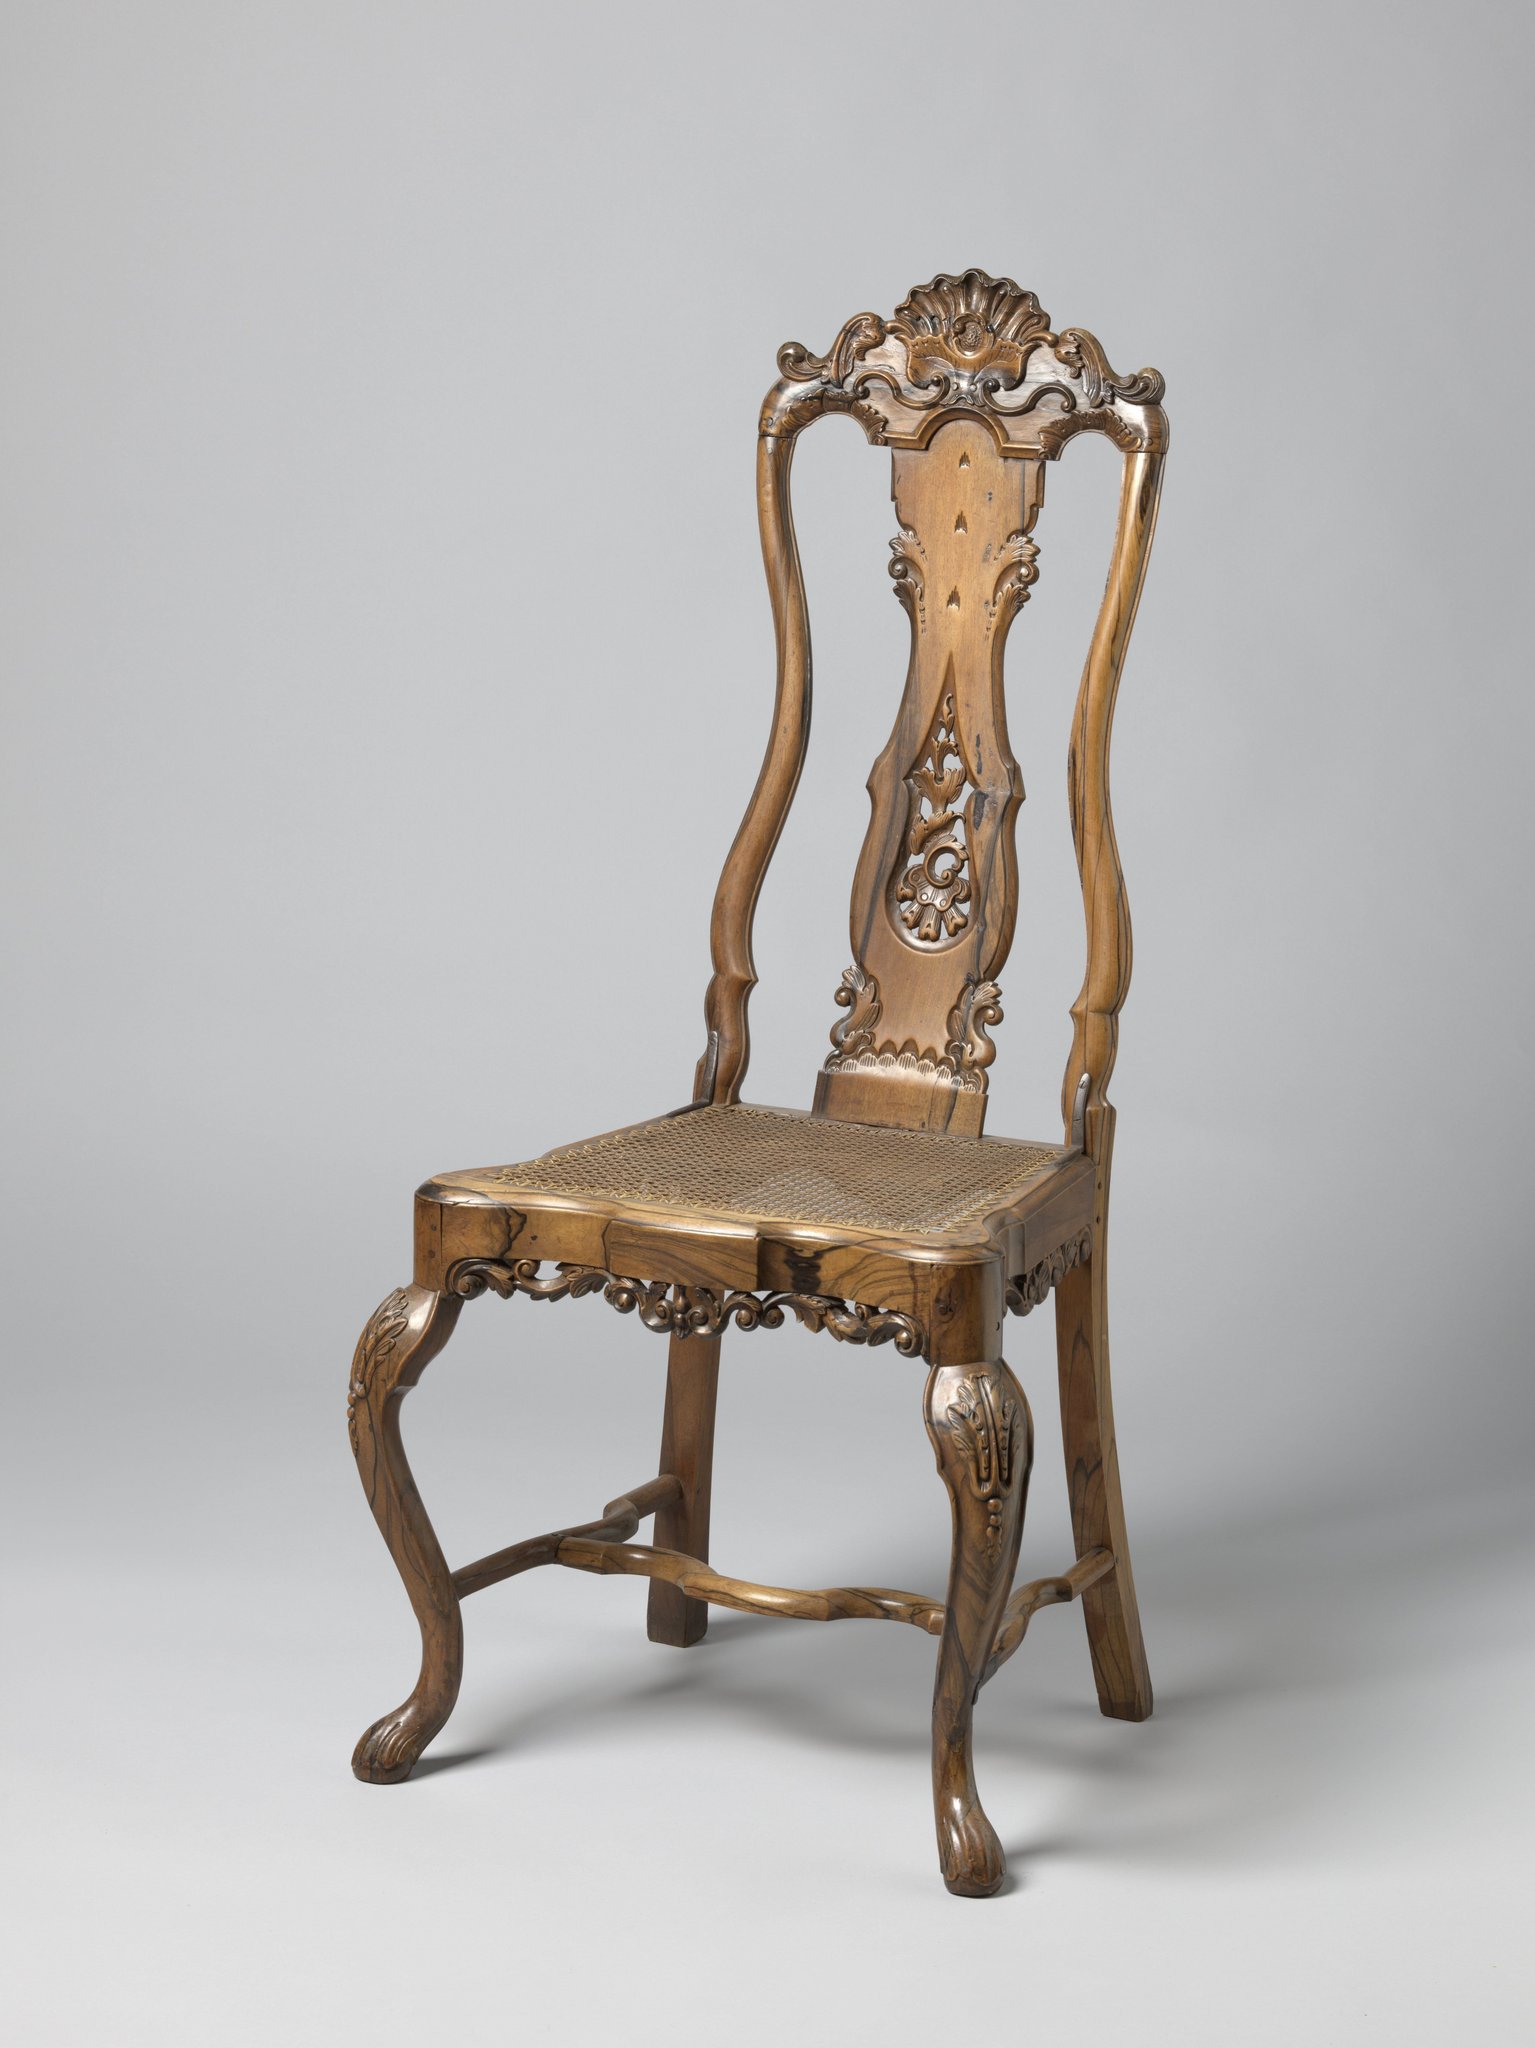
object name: chair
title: Stoel met rotan zitting. Kap met kuif tussen S-vormige voluten en bladwerk, aan onderkant drie boogvormen met rocaillemotief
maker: Anonymous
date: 1750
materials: wood, rattan, steel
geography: sri lanka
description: Chaire. Ebony. Ceylon (?), c. 1750.